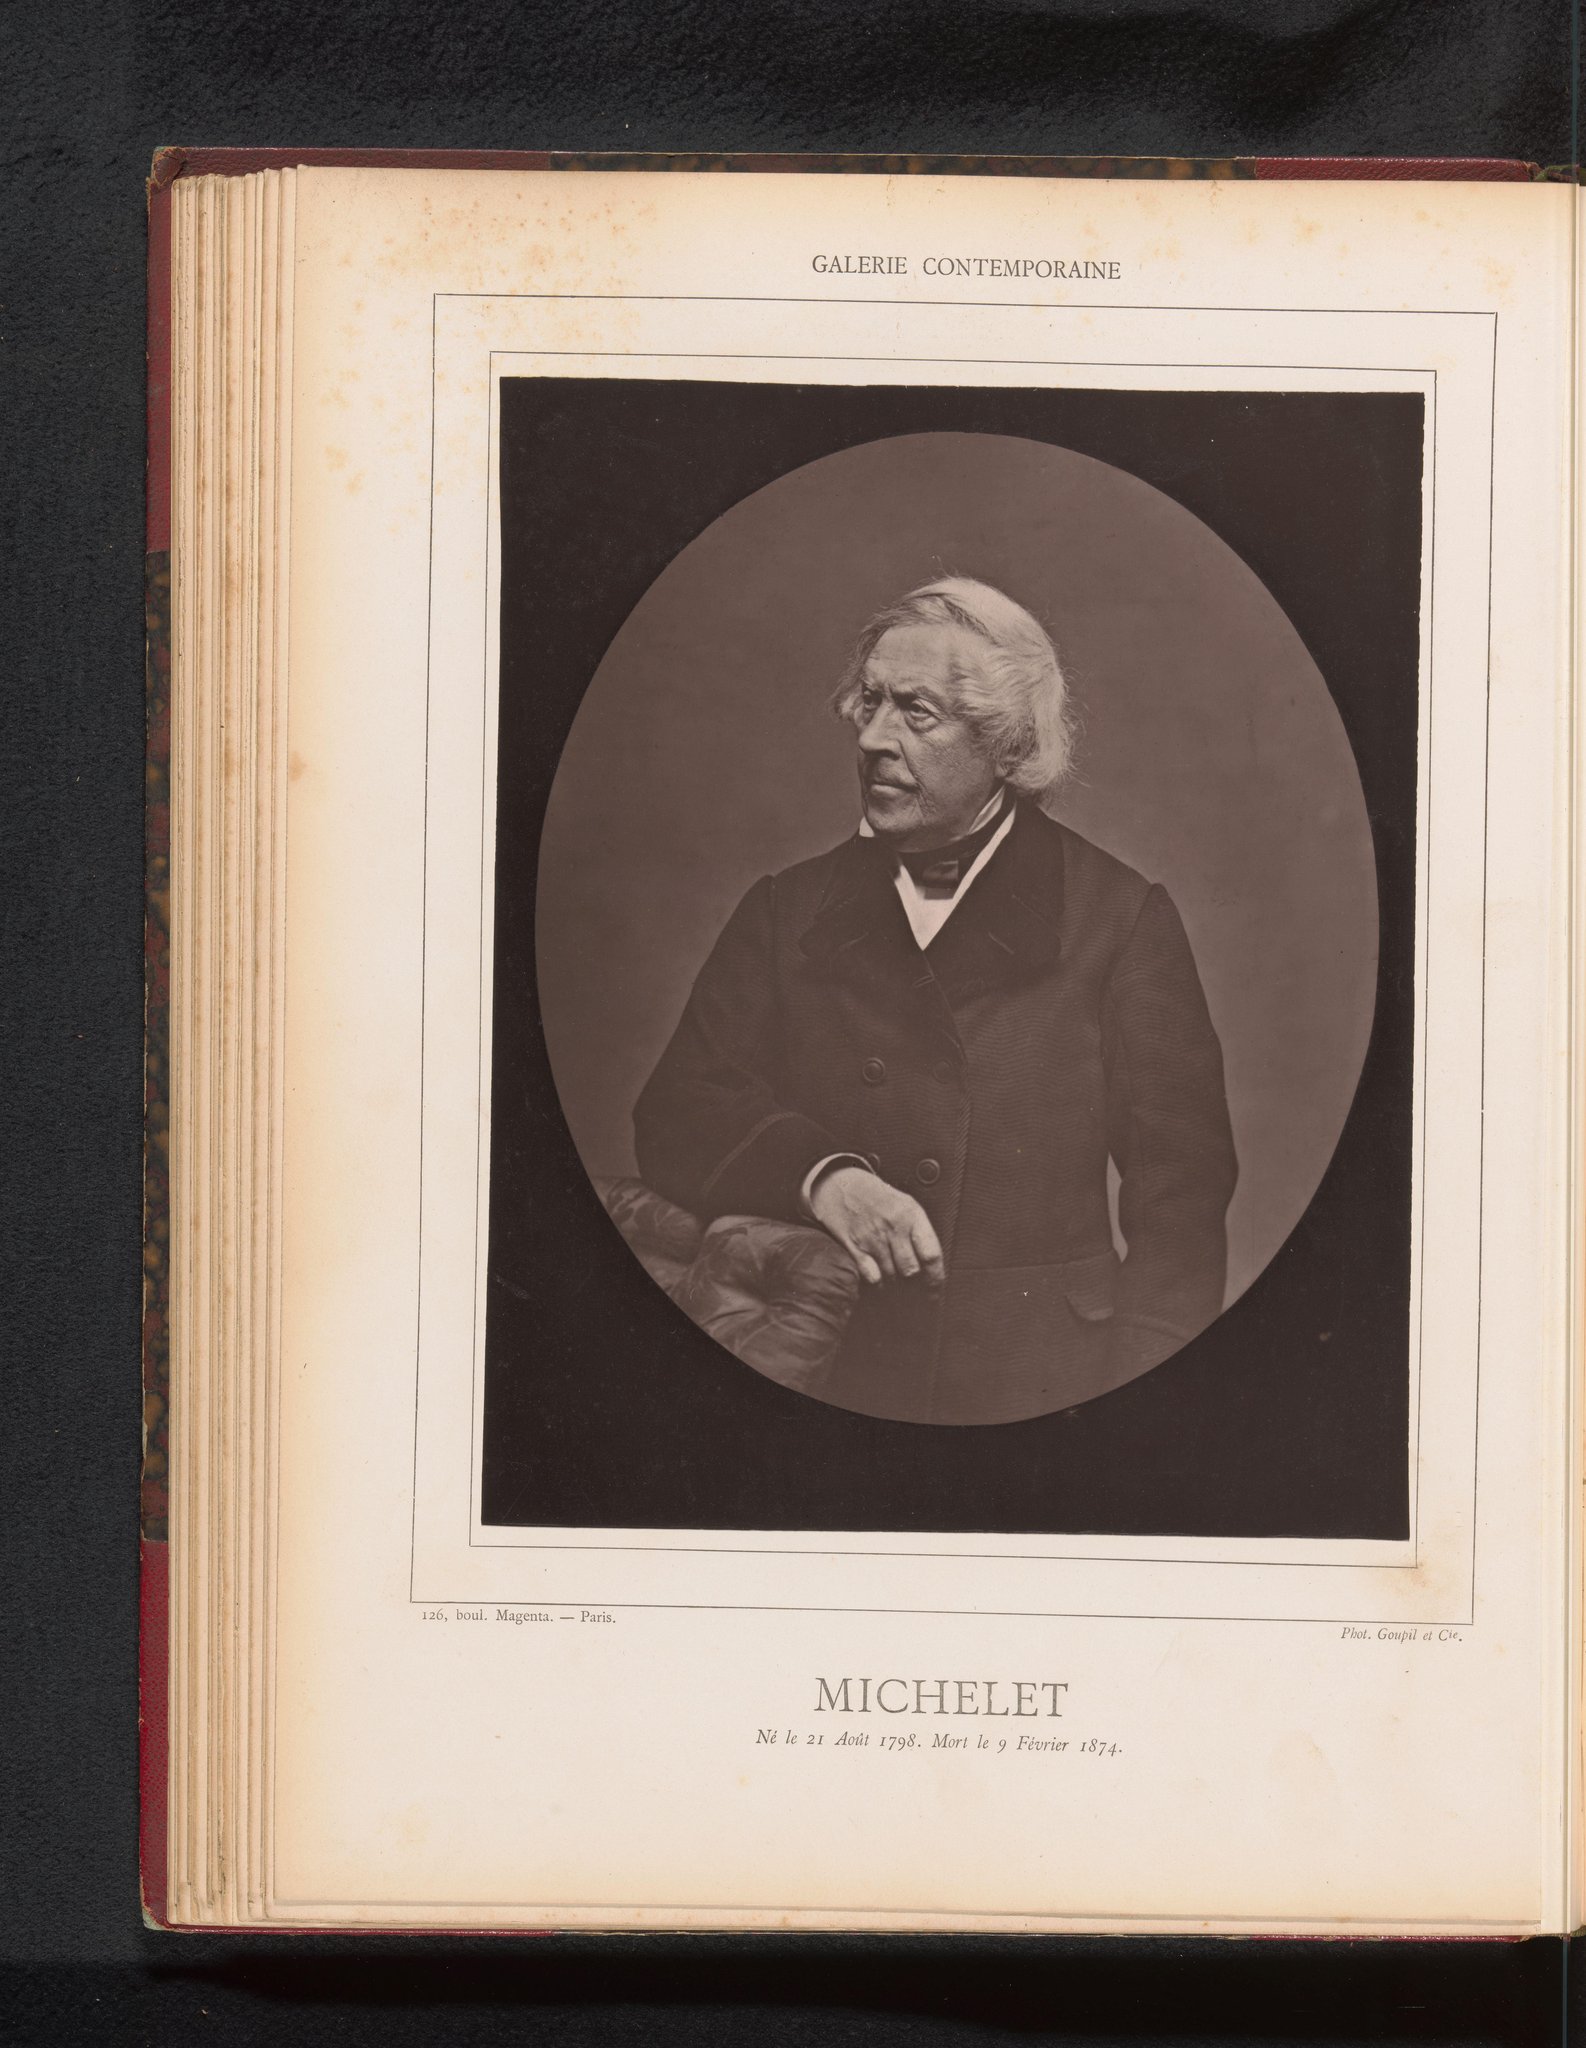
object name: photomechanical print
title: Michelet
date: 1871-1876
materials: paper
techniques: woodburytype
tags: paris, adult man, historical persons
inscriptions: inscription: ‘Né le Août 1798. Mort le 9 Fevrier 1874.’